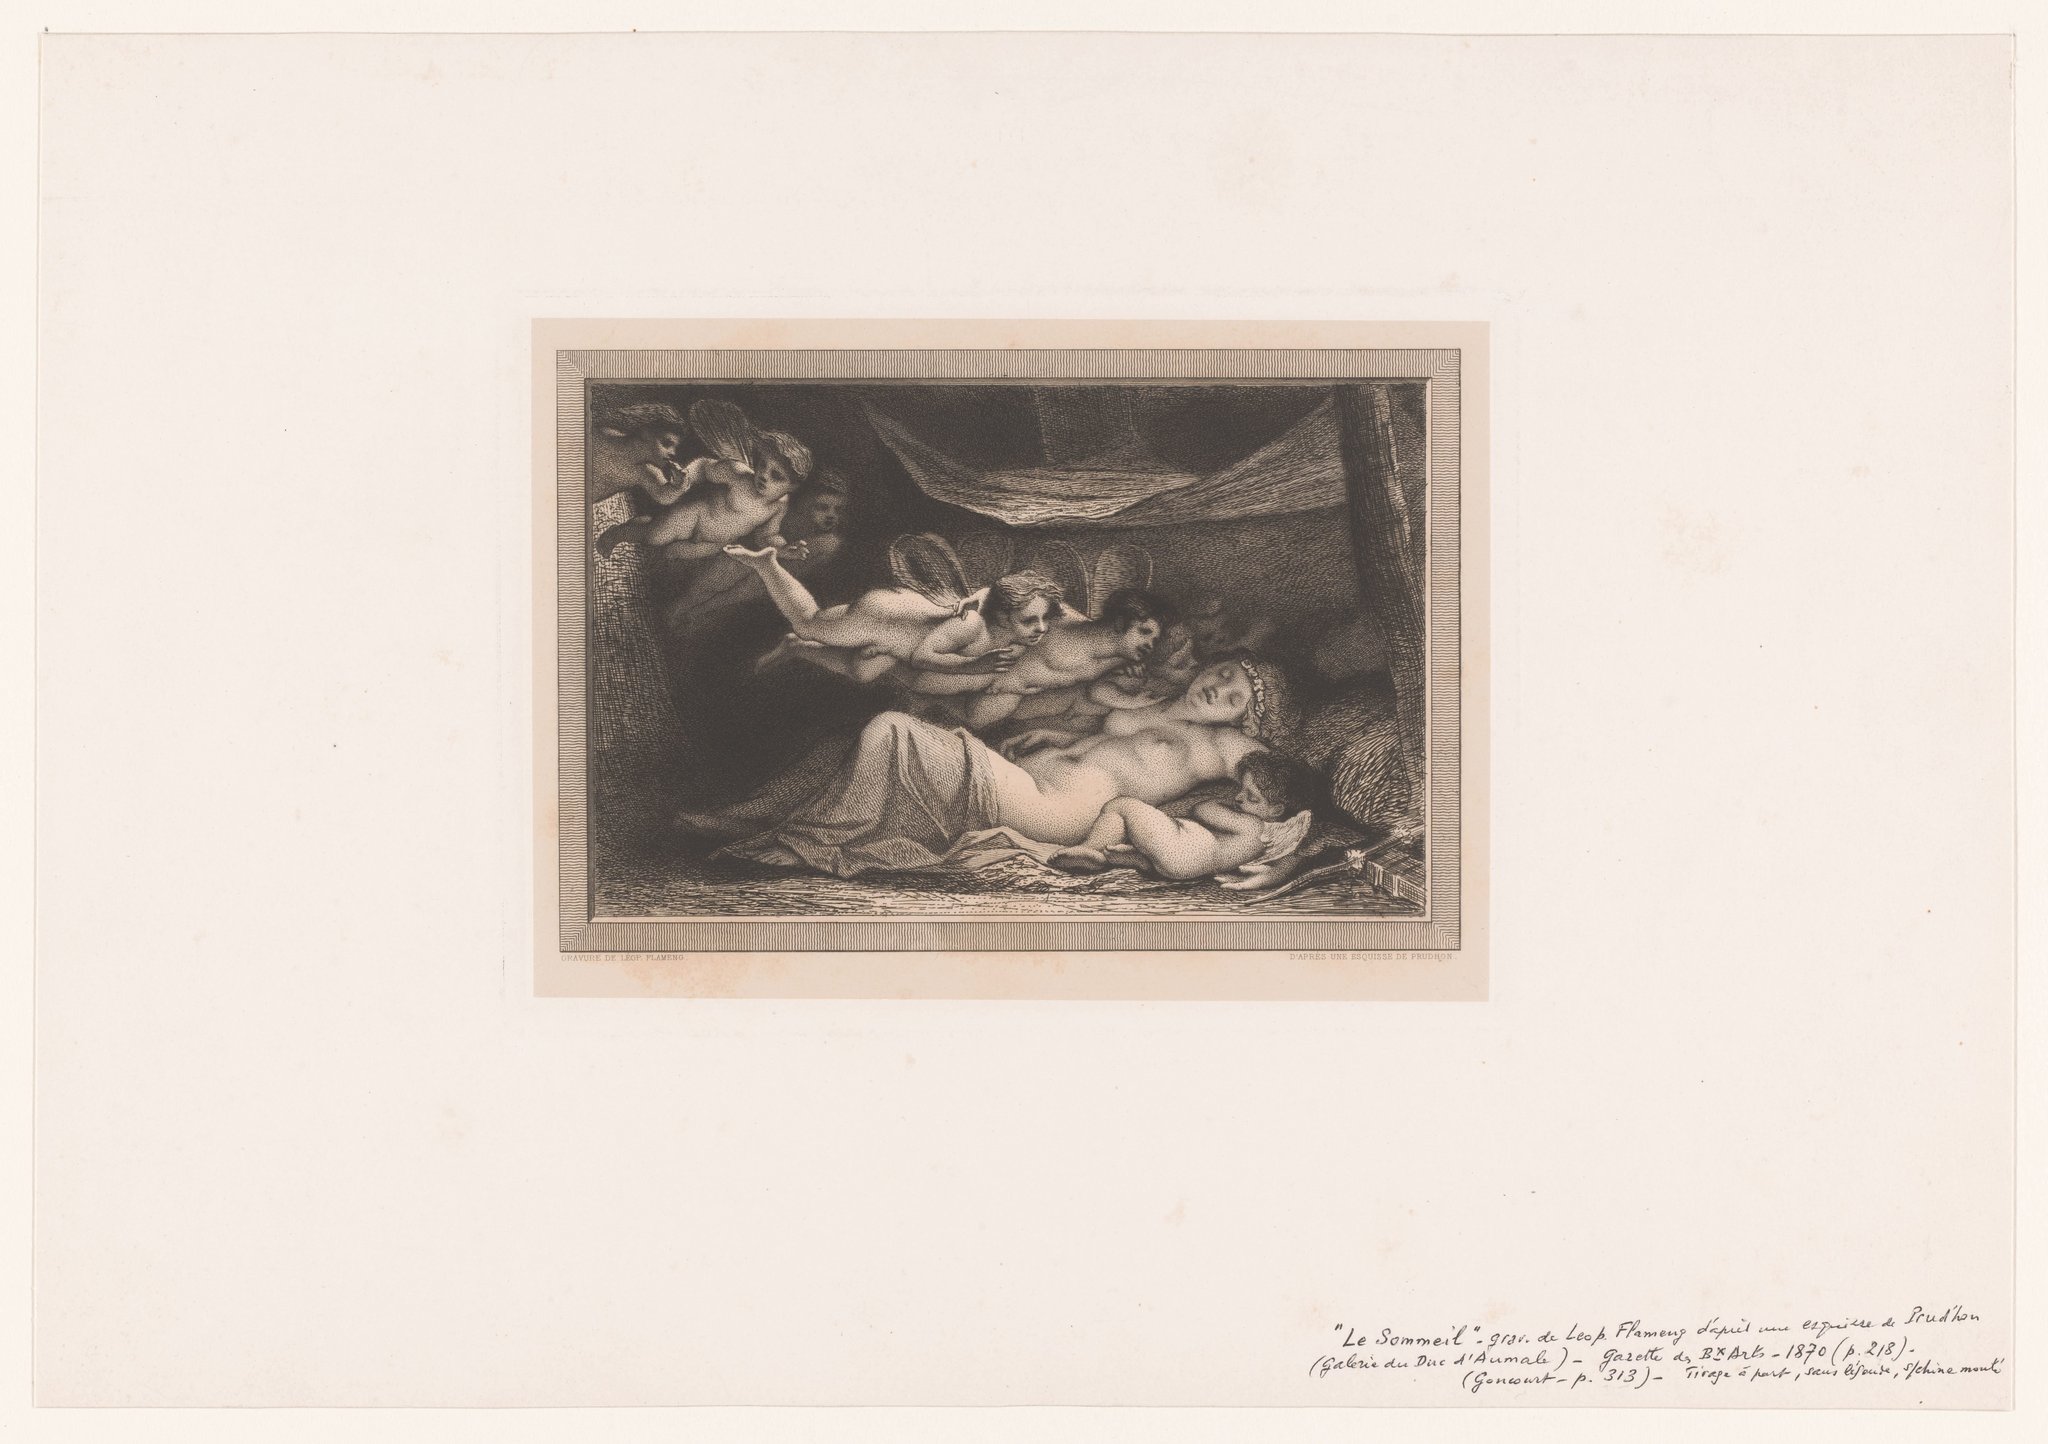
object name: print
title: Dromende Psyche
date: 1841-1911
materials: paper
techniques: engraving, etching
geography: paris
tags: psyche, on her way back, opens proserpina's casket and is overcome by sleep, (story of) cupid, amor (eros), cupids: 'amores', 'amoretti', 'putti'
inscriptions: collector's mark: Lugt 2228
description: Prent uit: Gazette des Beaux Arts, 1870, p. 218.